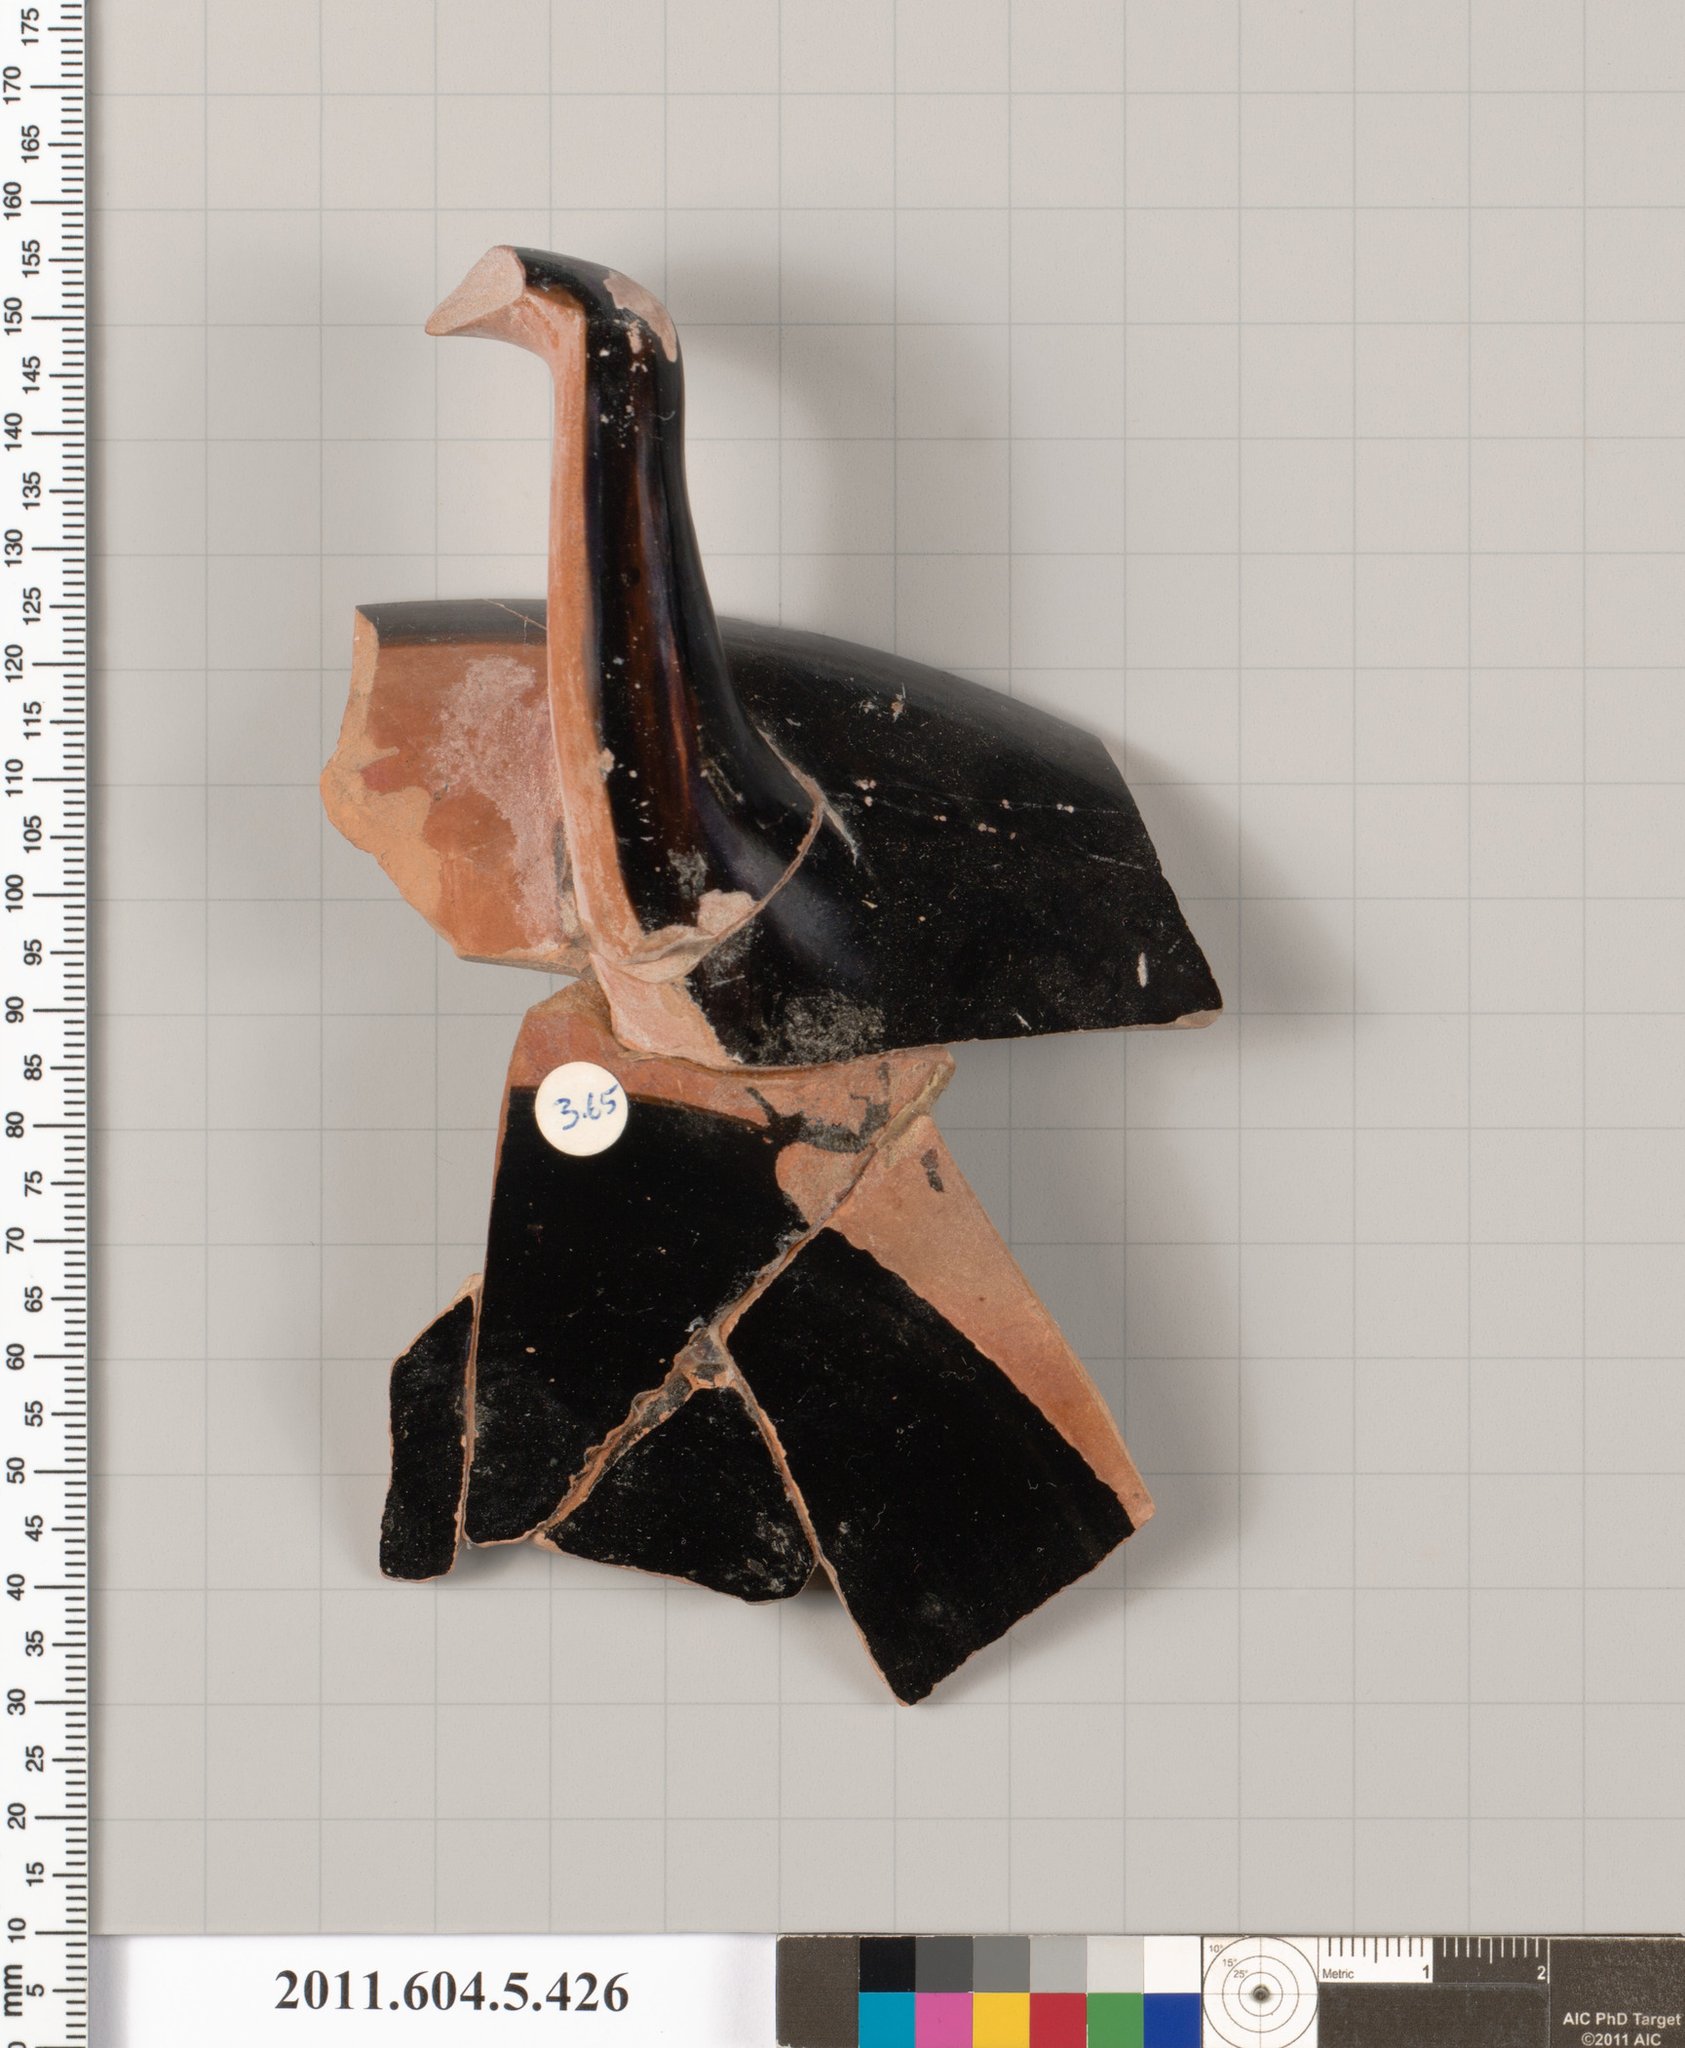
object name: kylix fragment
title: Terracotta rim fragment of a kylix (drinking cup)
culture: greek, attic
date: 600-401 BCE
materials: terracotta